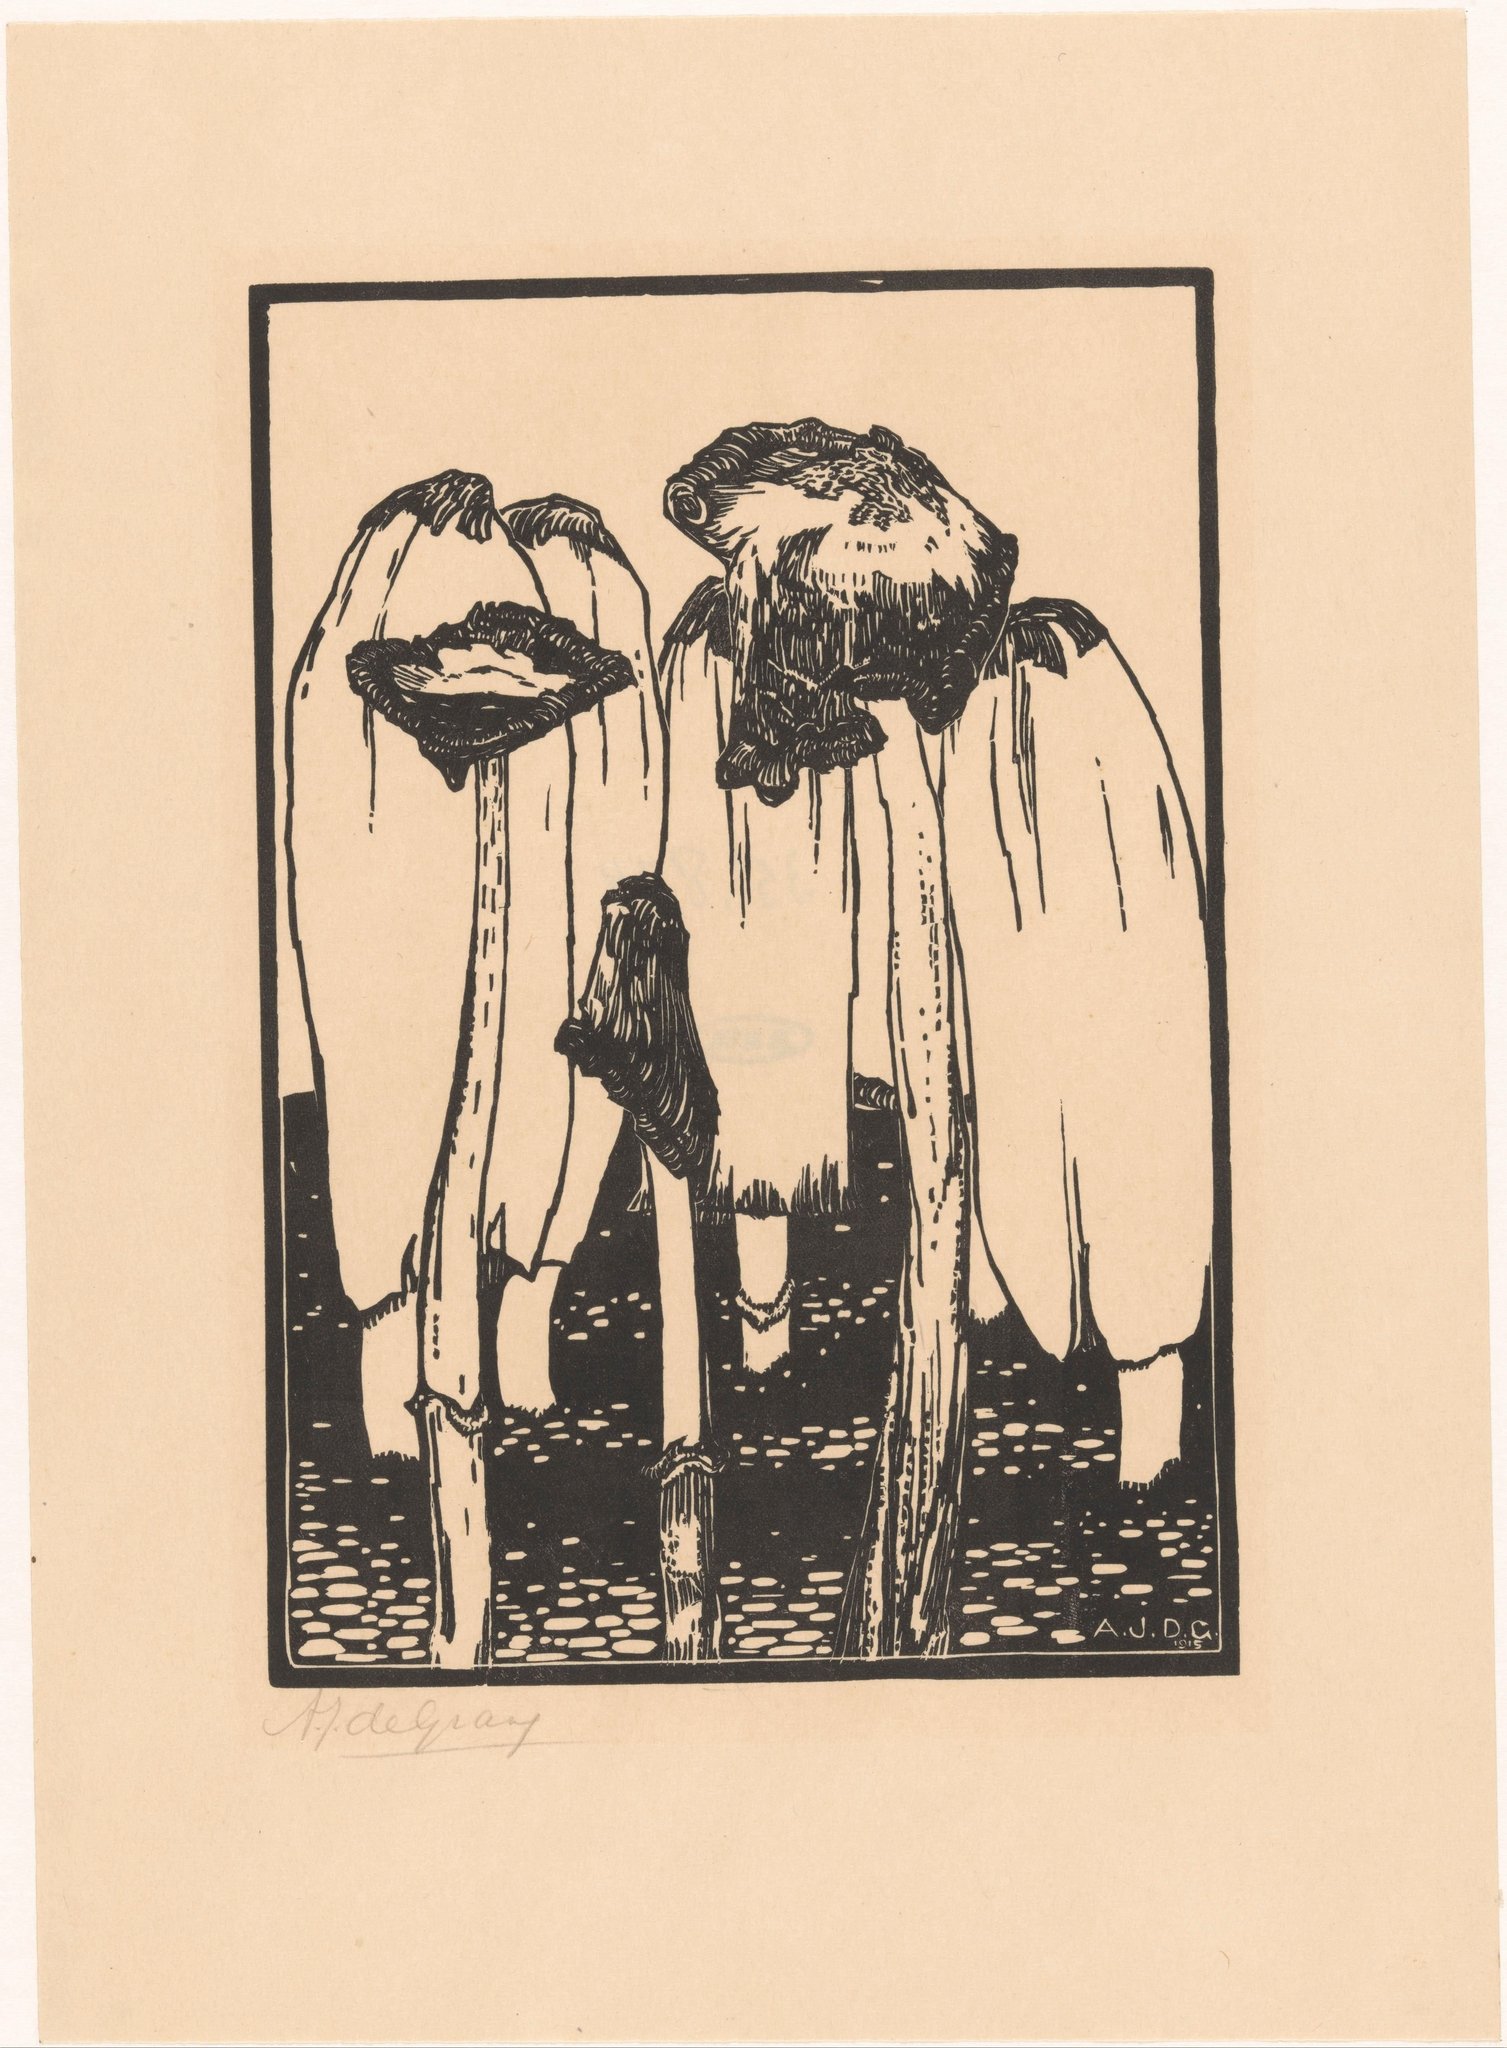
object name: print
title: Inktzwammen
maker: julie de graag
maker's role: draughtsman, print maker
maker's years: 1877-1924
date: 1915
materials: paper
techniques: woodcut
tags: mushrooms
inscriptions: collector's mark: Lugt 2228